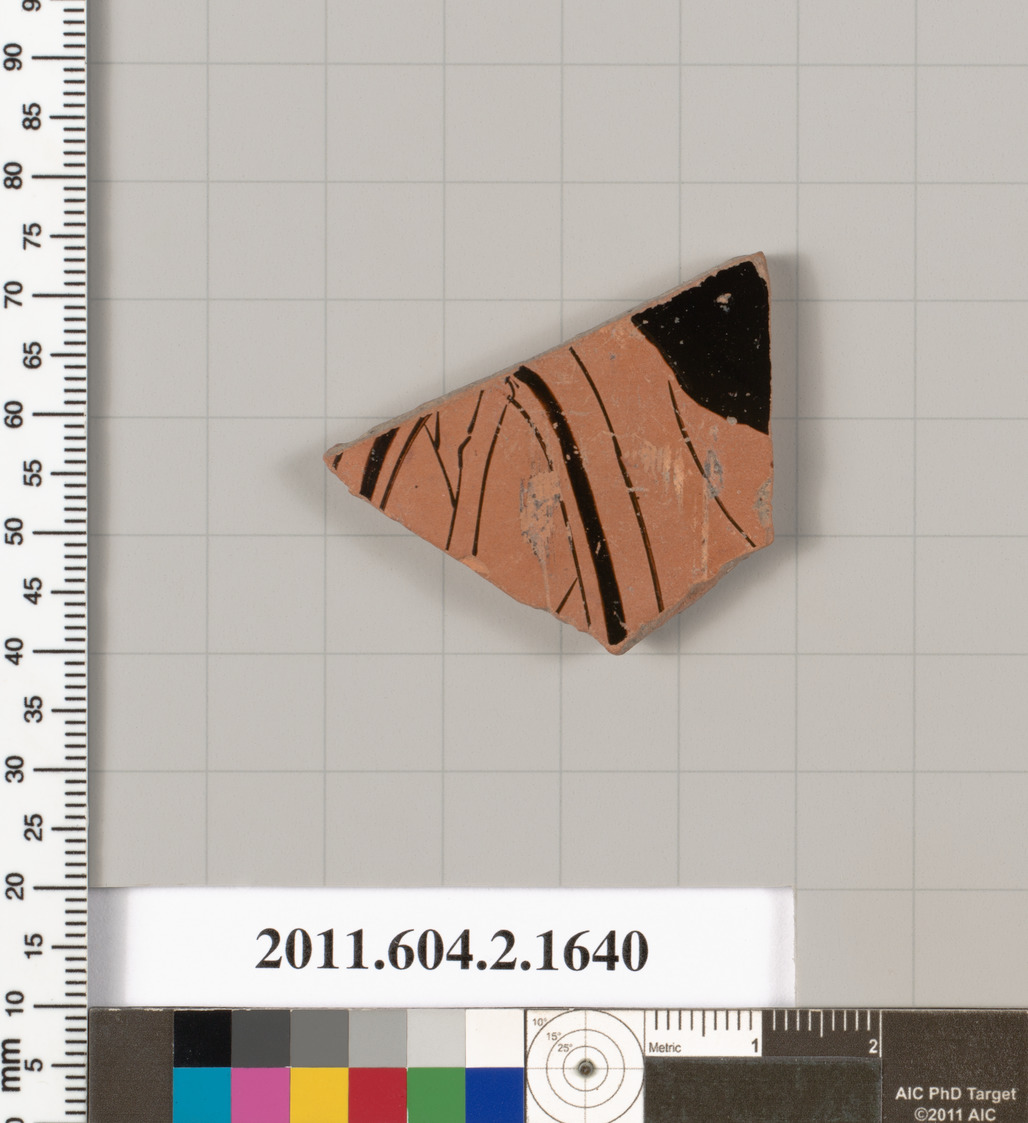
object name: skyphos fragment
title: Terracotta fragment of a skyphos (deep drinking cup)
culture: greek, attic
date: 460-440 BCE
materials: terracotta